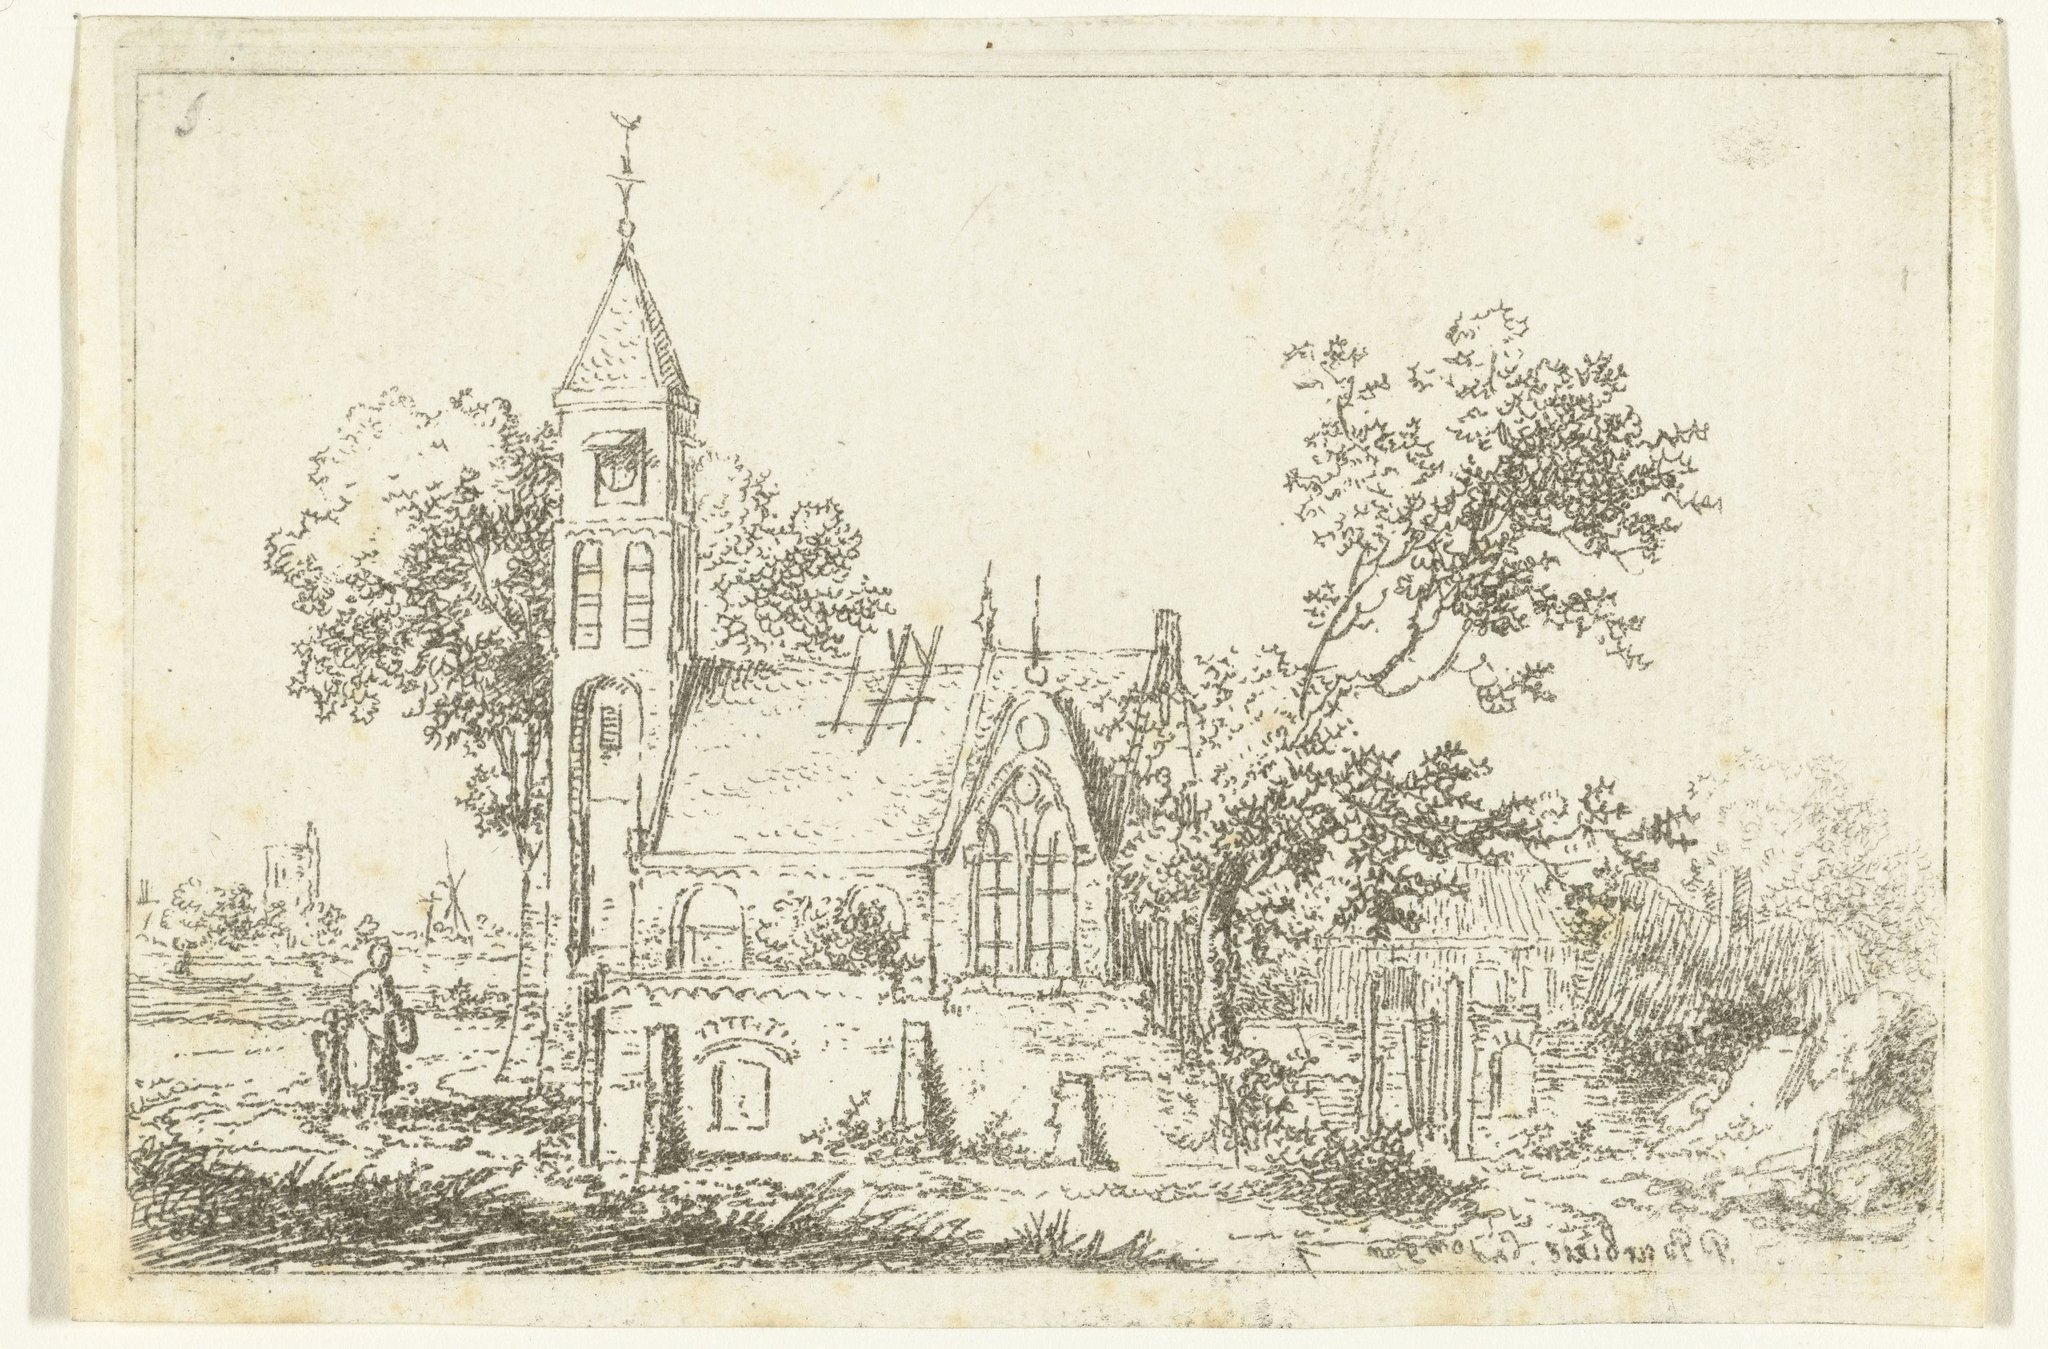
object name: print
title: Landschap met kerk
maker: pieter barbiers (iv)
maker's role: painter, print maker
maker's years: 1798-1848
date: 1808-1848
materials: paper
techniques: printmaking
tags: church (exterior)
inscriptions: collector's mark: Lugt 2228, collector's mark: Lugt 1485